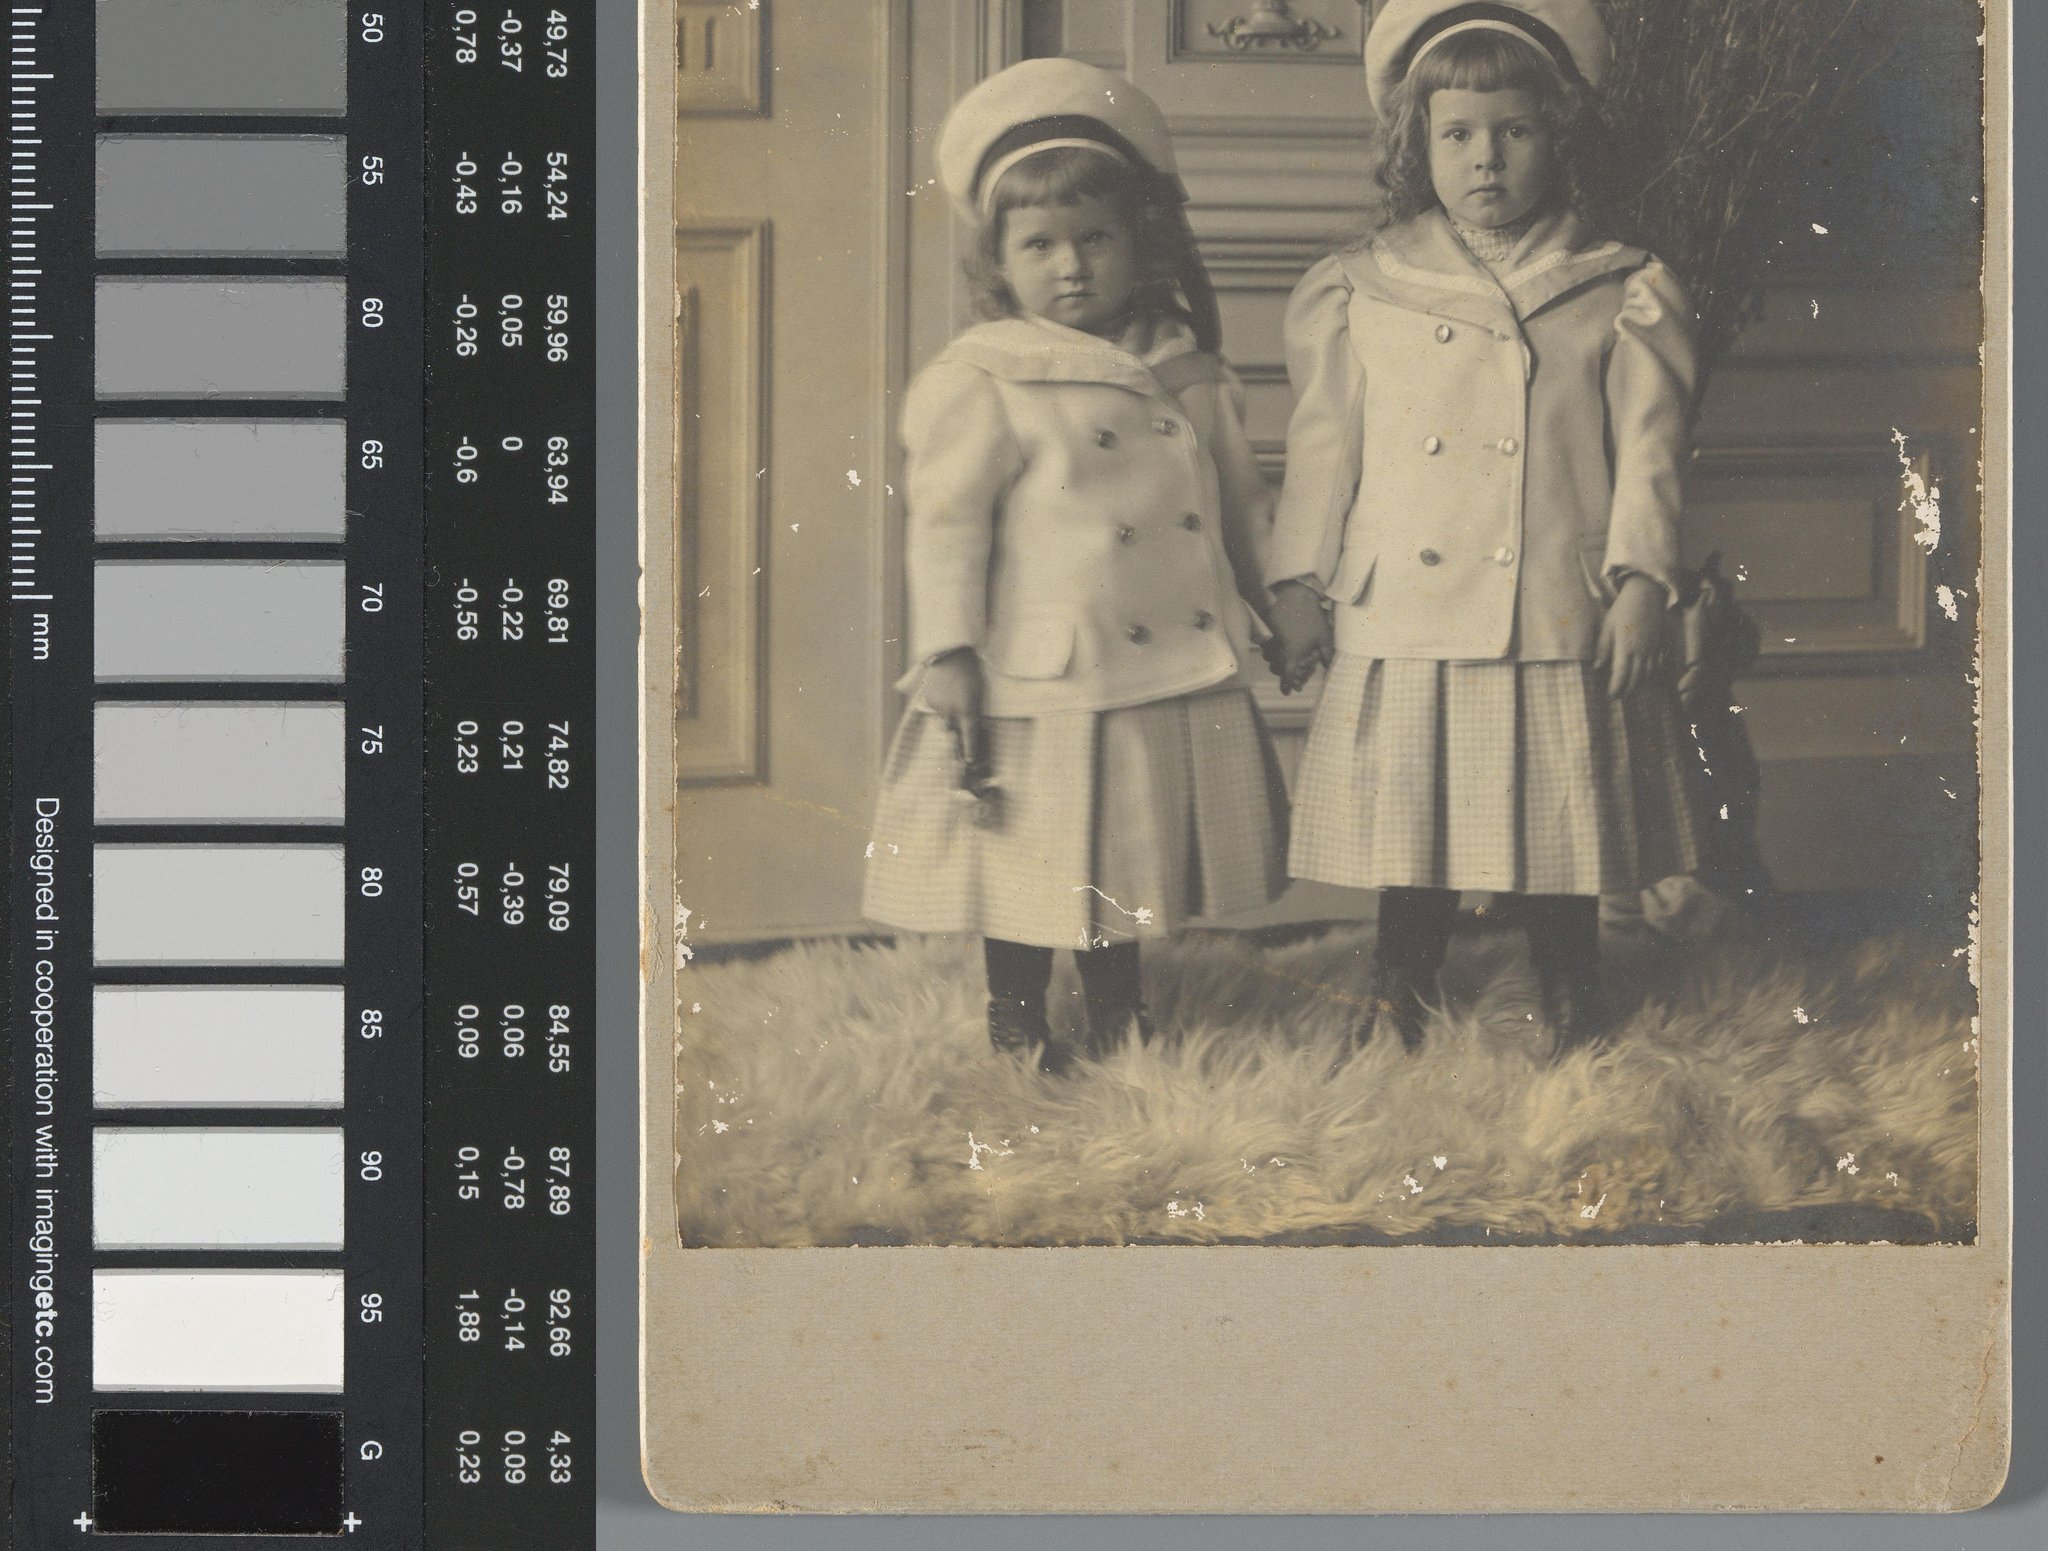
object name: photograph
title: Twee meisjes staand in de salon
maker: Anonymous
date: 1890-1920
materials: cardboard, photographic support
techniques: albumen print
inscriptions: inscription: ‘... + Lien / in de salon v/h. huis Ned. Bank’